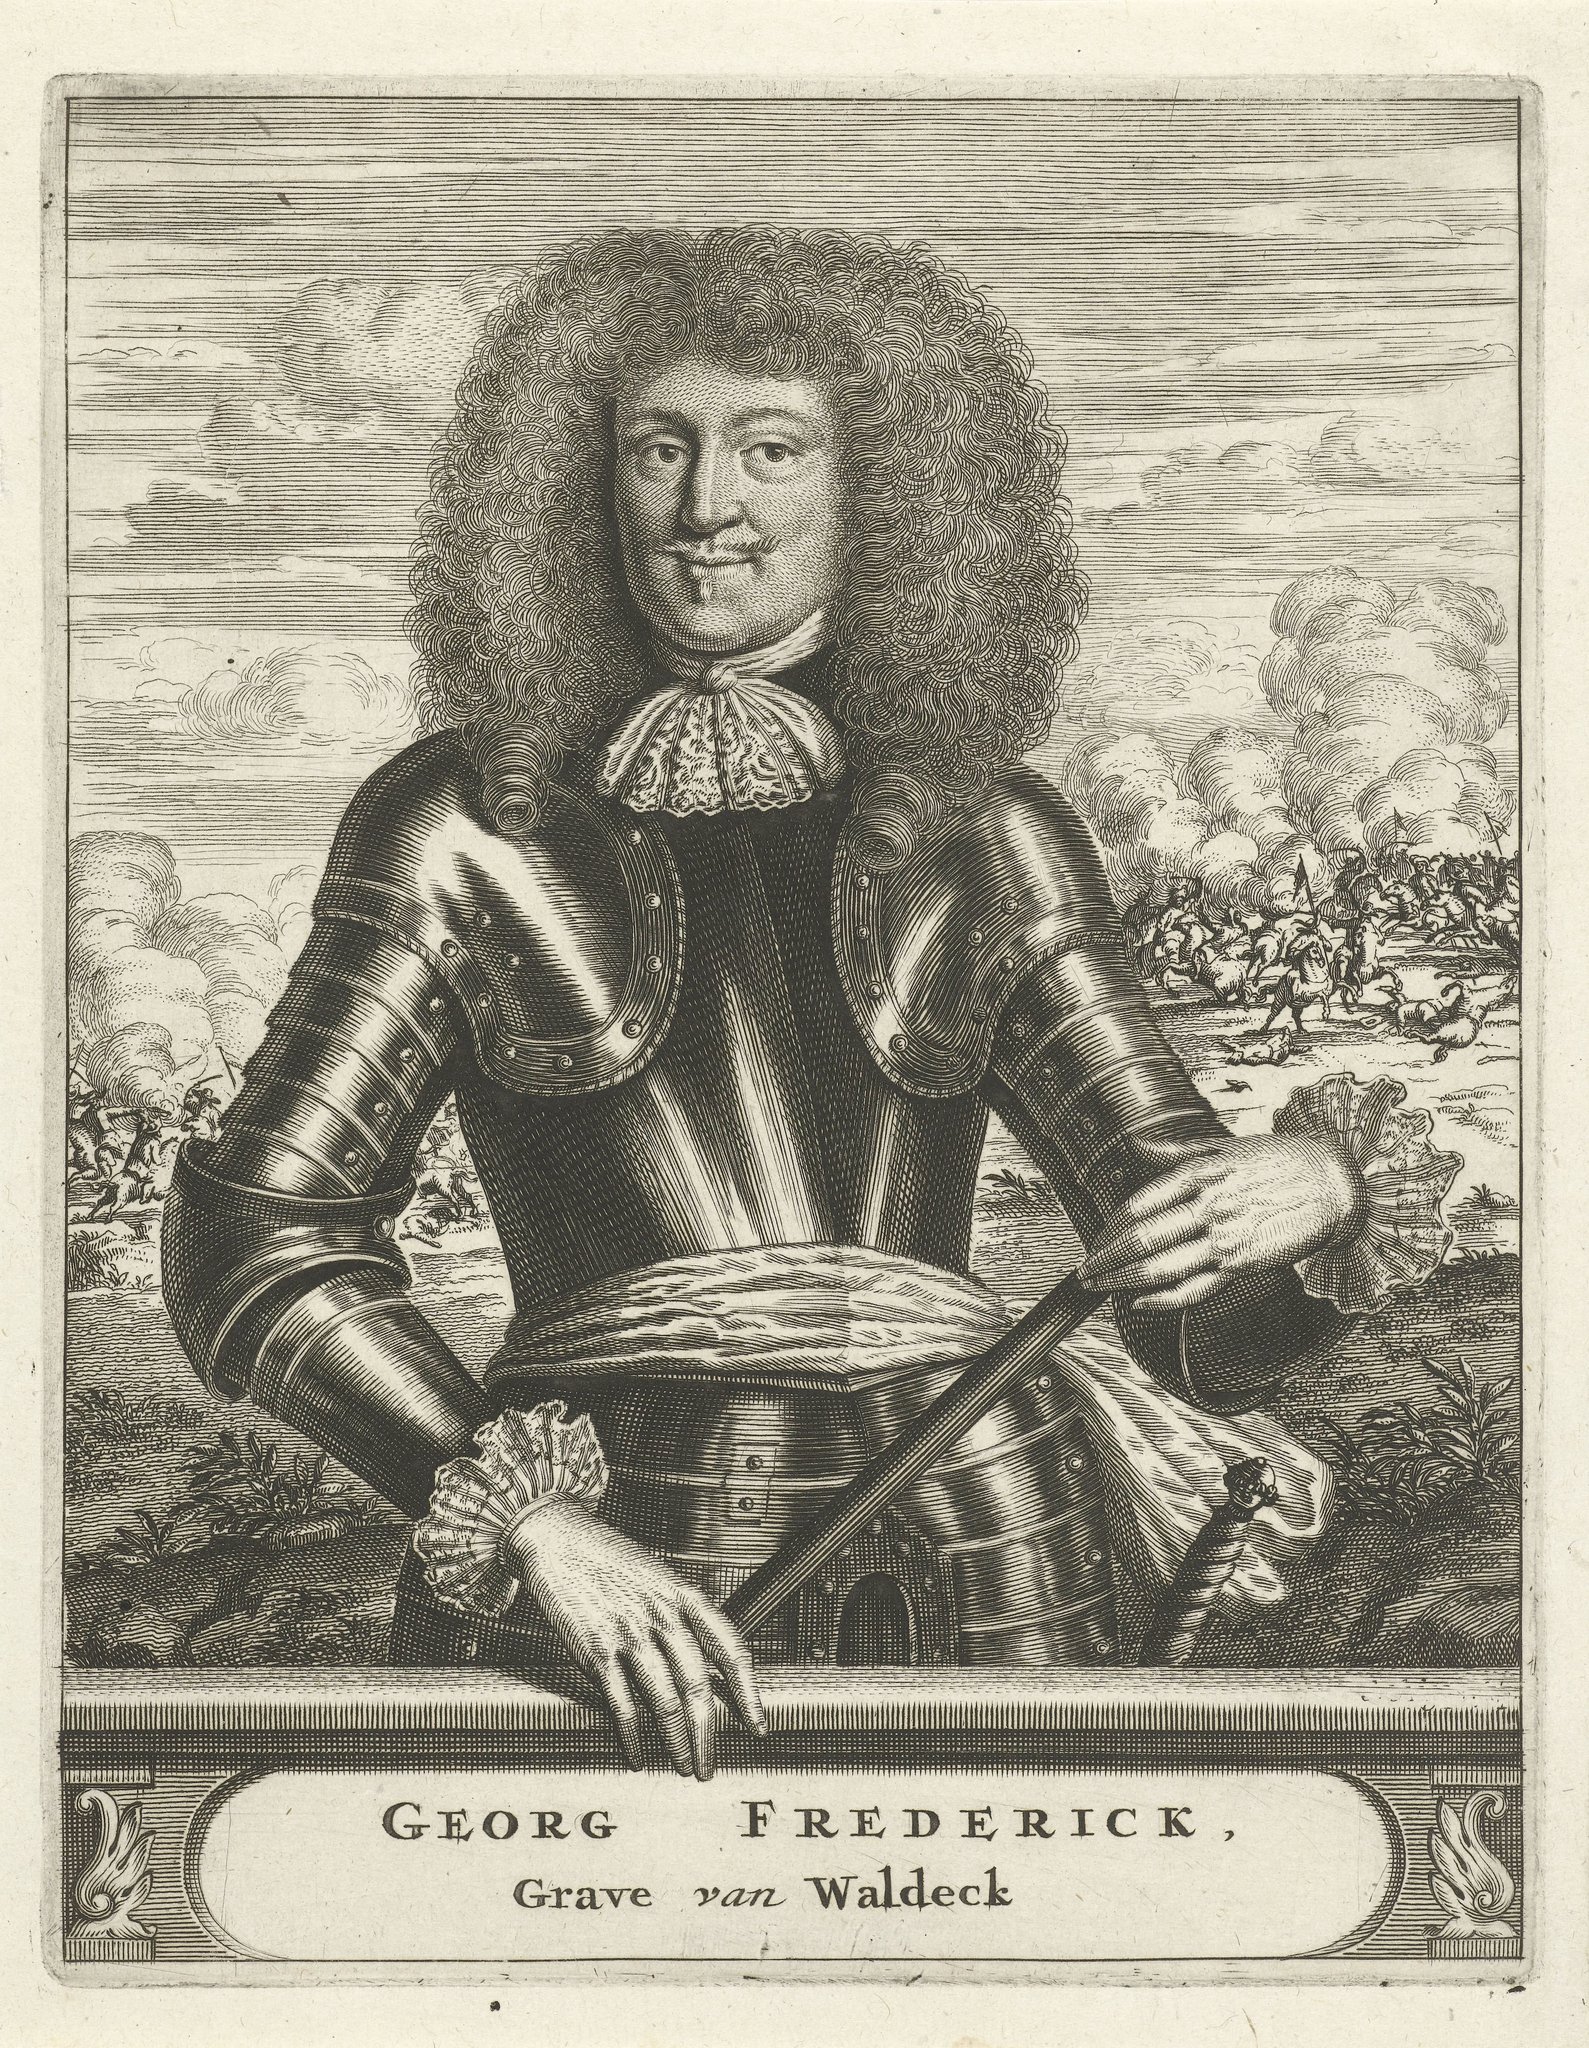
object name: print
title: Portret van Georg Friedrich, prins van Waldeck-Eisenberg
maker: christiaan hagen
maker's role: draughtsman, print maker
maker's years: 1635-1707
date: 1663-1695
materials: paper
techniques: engraving, etching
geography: amsterdam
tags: belt, girdle, waistband, armour, battle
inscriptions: collector's mark: Lugt 2228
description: Portret van Georg Friedrich, prins van Waldeck-Eisenberg, gekleed in een harnas. In zijn handen houdt hij een commandostaf. Op de achtergrond is een veldslag afgebeeld. Onder zijn portret een plint, waarop zijn naam in twee regels in een cartouche.